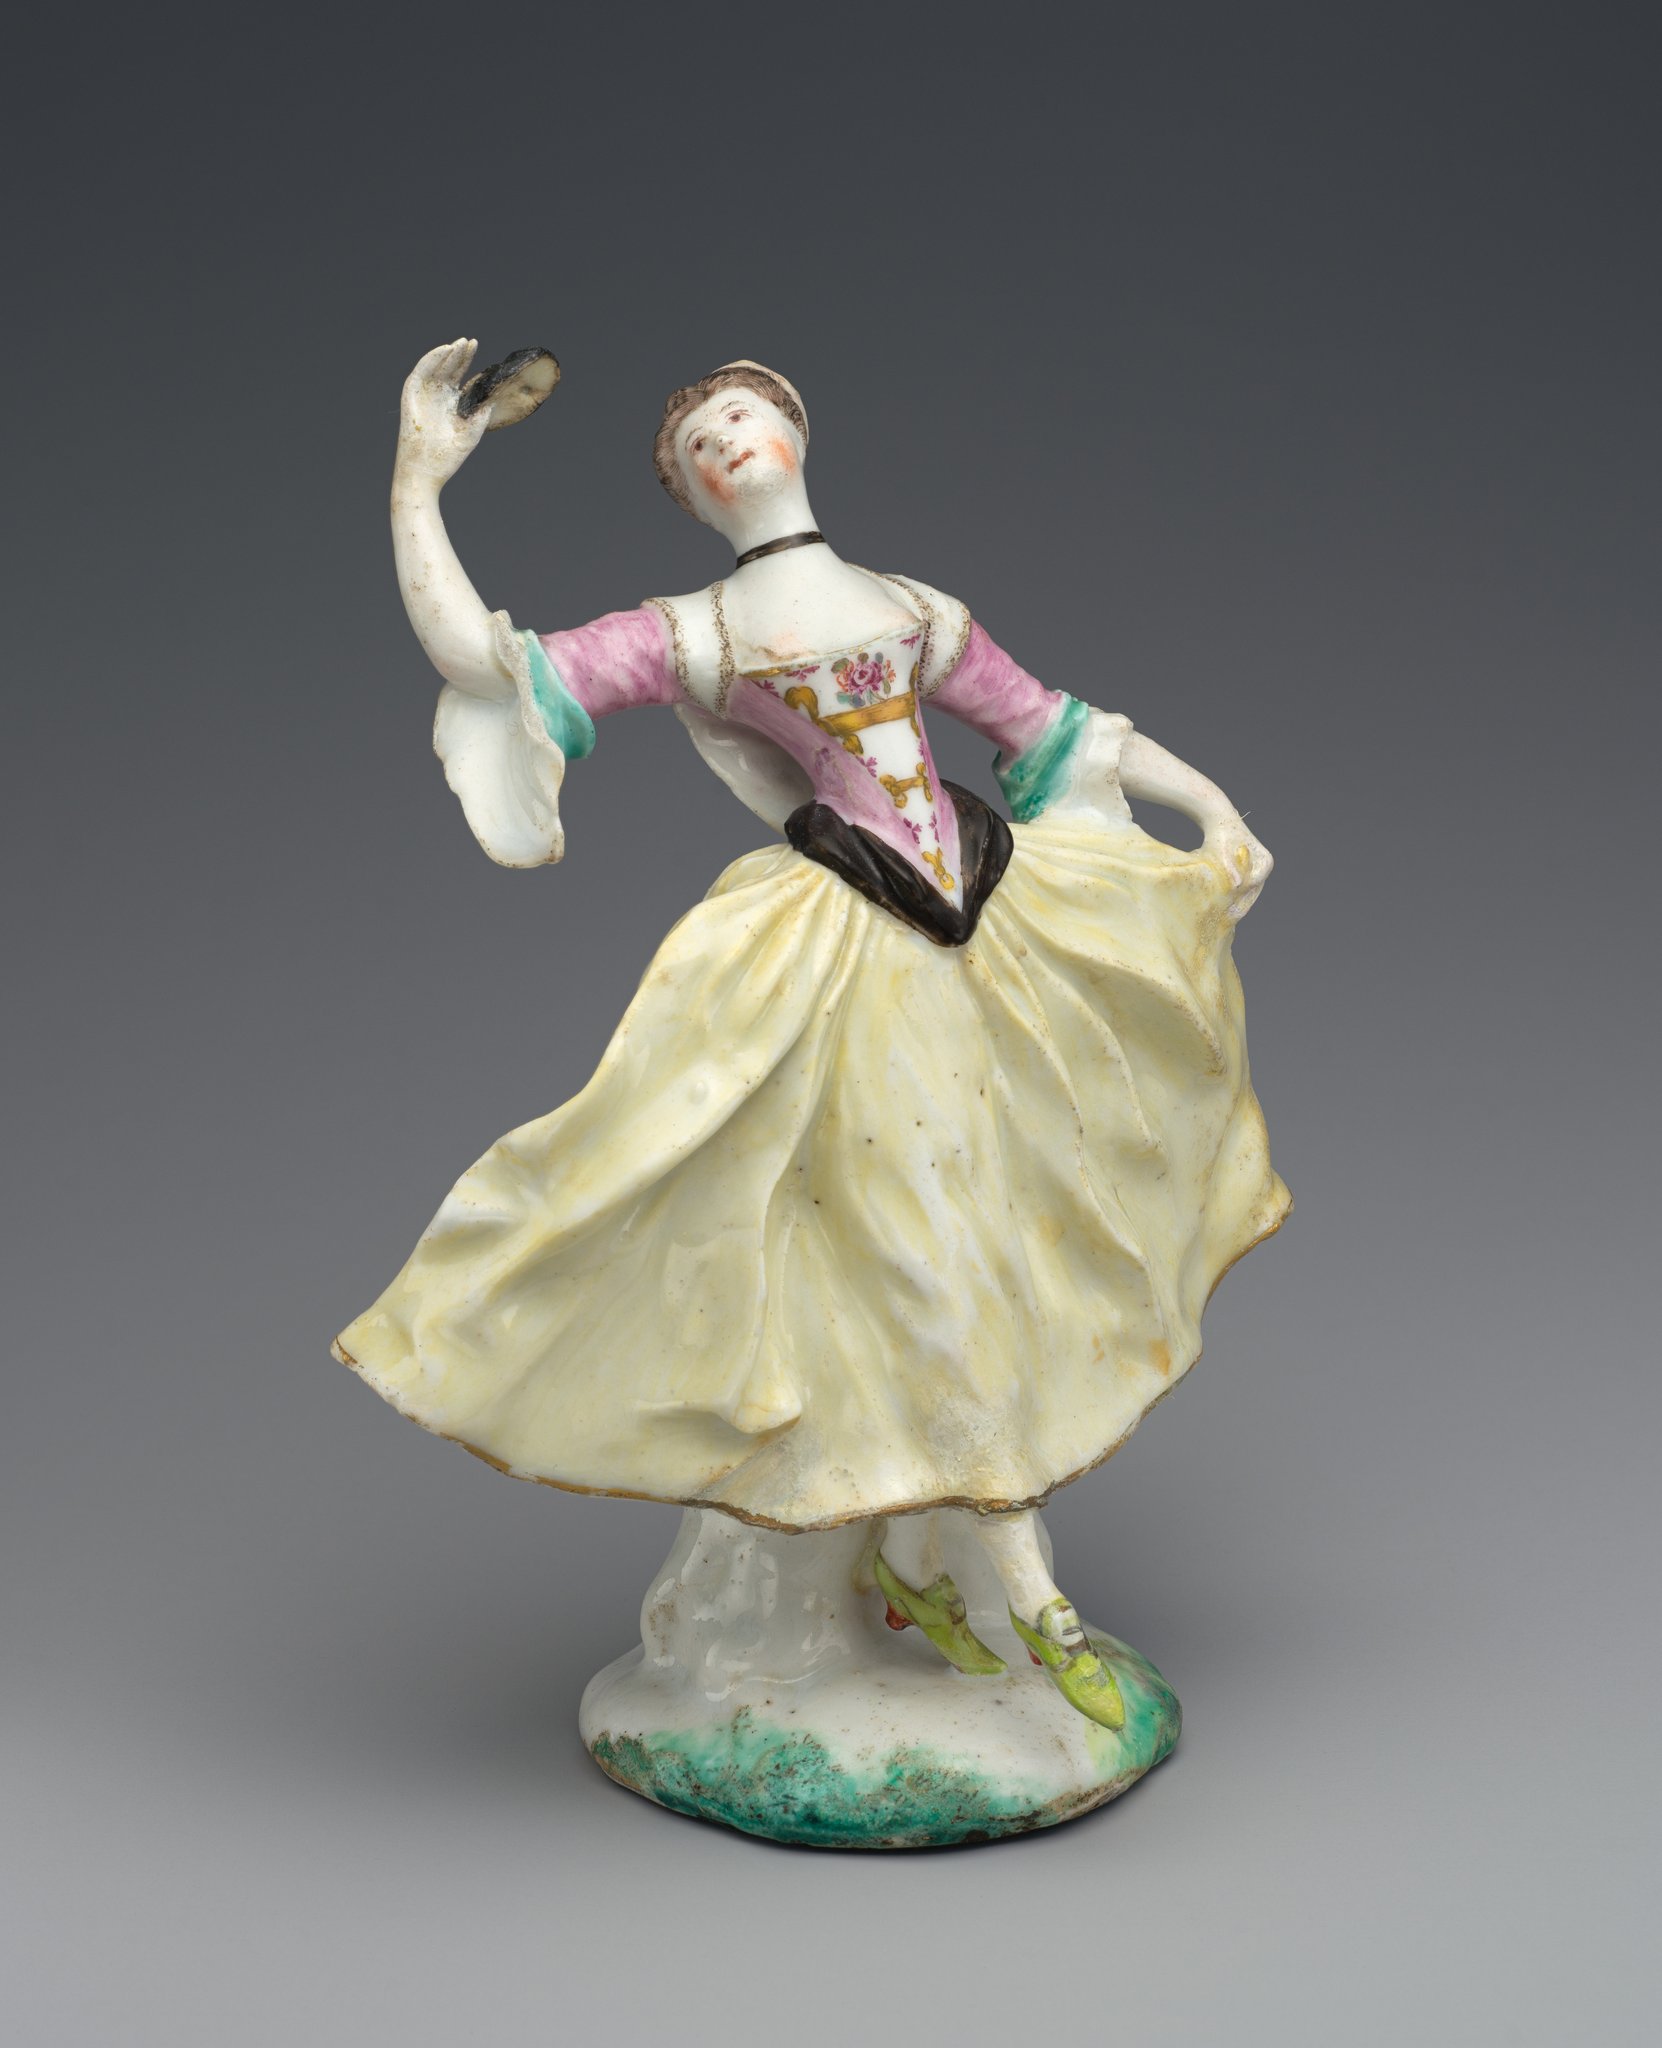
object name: figure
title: Dancer (one of a pair)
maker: derby porcelain manufactory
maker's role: factory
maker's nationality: british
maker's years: 1751-1785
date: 1750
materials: soft paste porcelain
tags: women,dancing,dancers